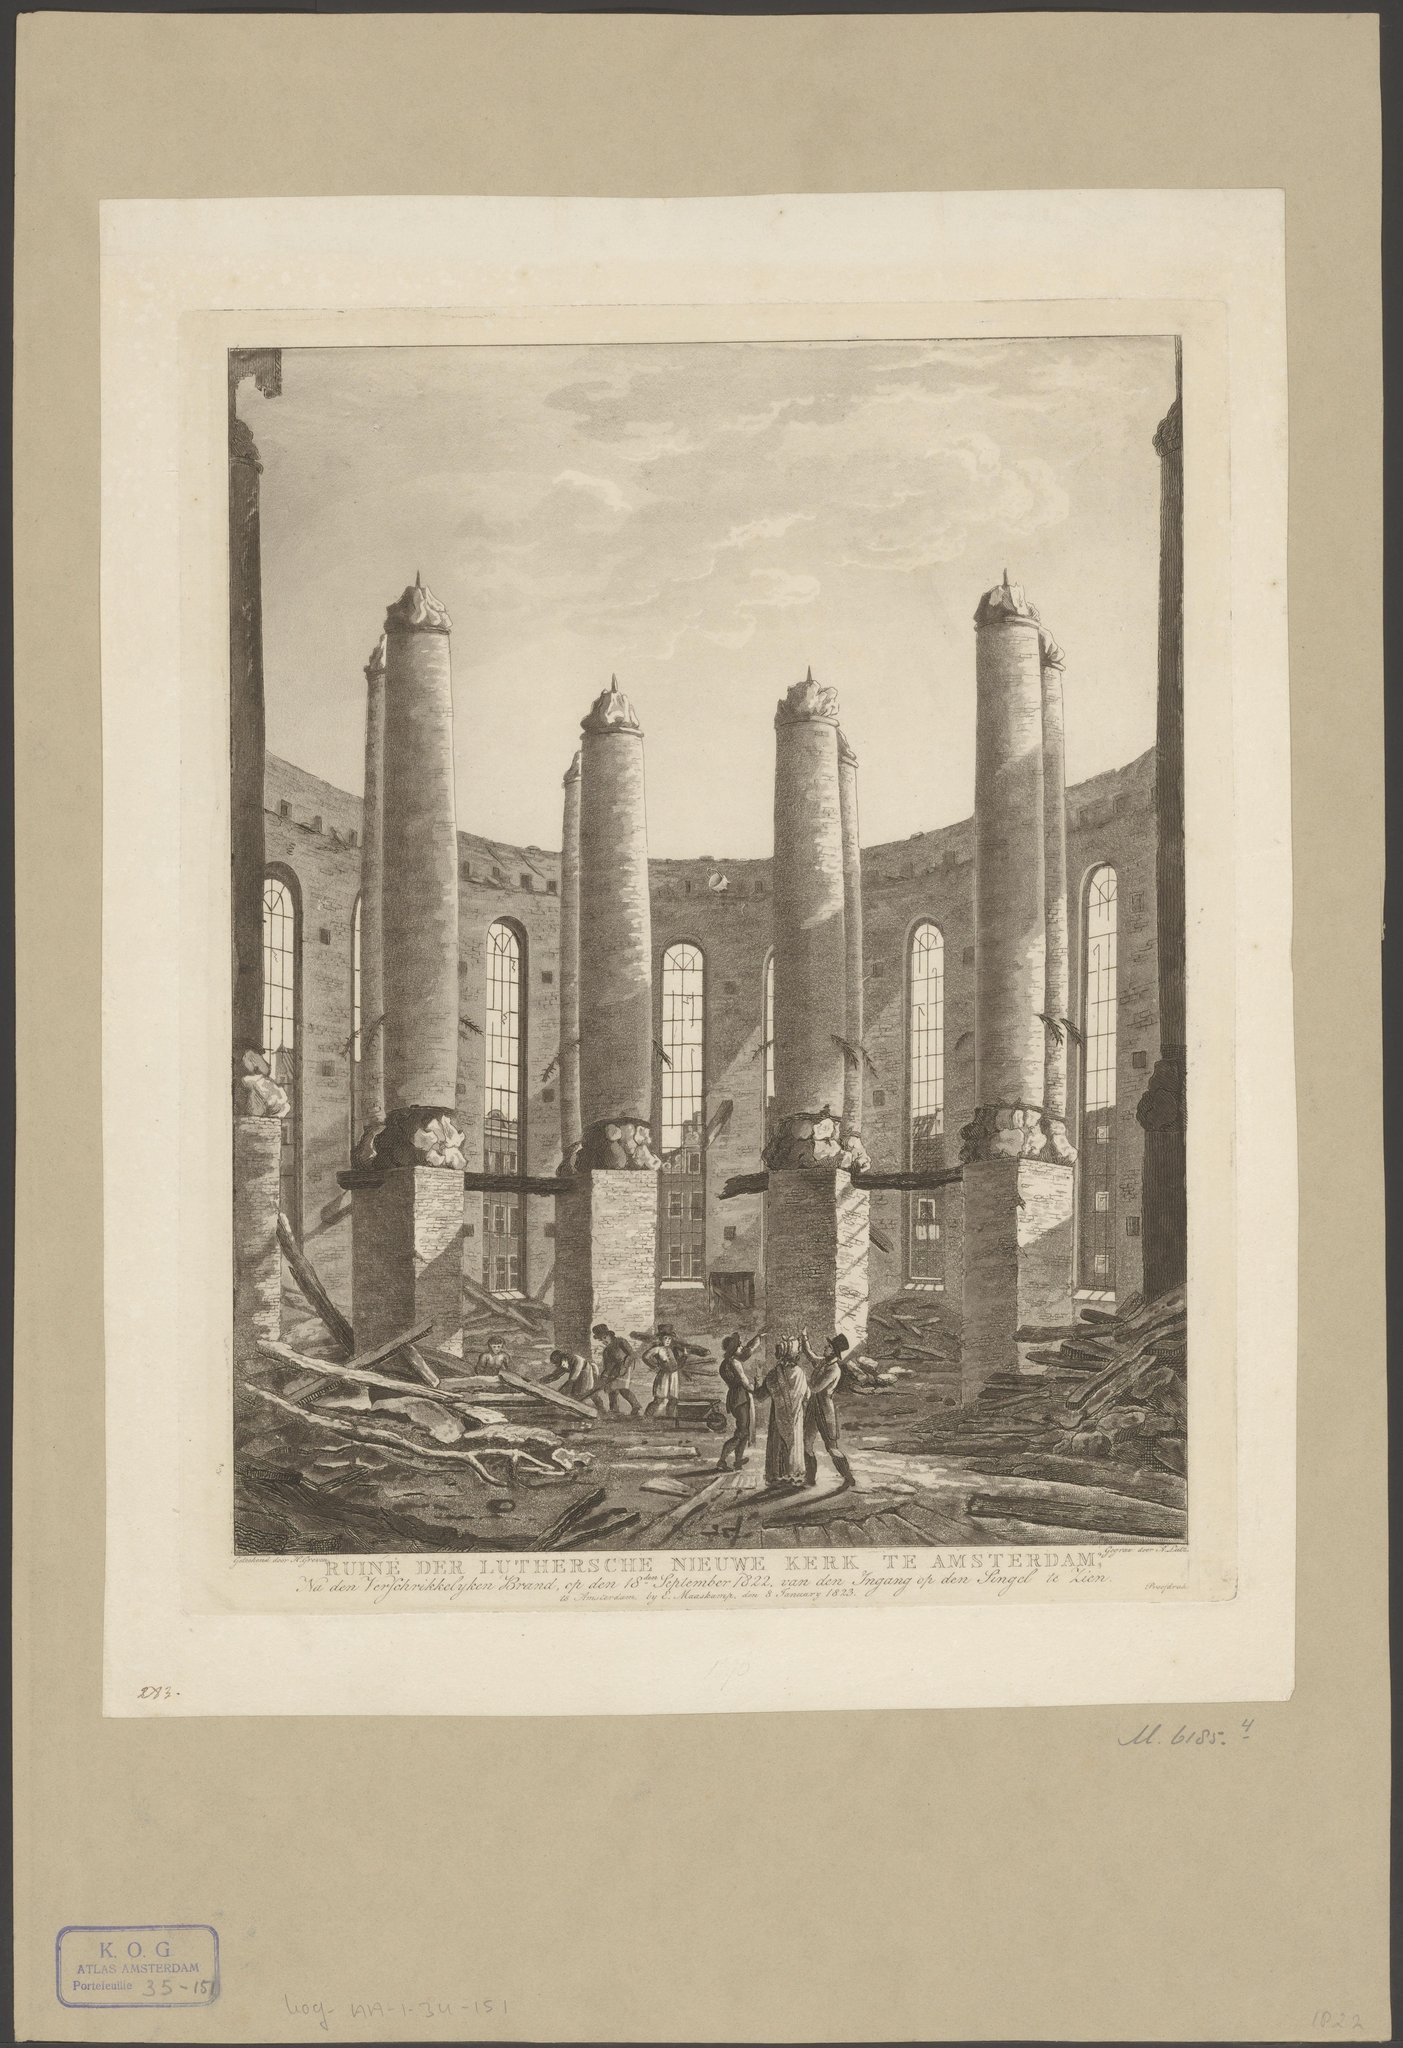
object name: print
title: Ruine der Luthersche Nieuwe Kerk te Amsterdam, Na den Verschrikkelyken Brand, op den 18den September 1822, van den Ingang op den Singel te Zien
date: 1823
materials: paper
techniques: aquatint, etching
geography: amsterdam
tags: on fire, ablaze, ruin of a building ~ architecture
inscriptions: collector's mark: Lugt 1641b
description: Gezicht op de ruïne van de Nieuwe Lutherse Kerk op het Singel te Amsterdam, na de brand op 18 september 1822. Onderwerpsrubriek binnen de Atlas Amsterdam: Kerkwezen: Ev. Lutherse Gemeente: 1822 Brand in de Nieuwe Luthersche Koepelkerk - Ruïne.